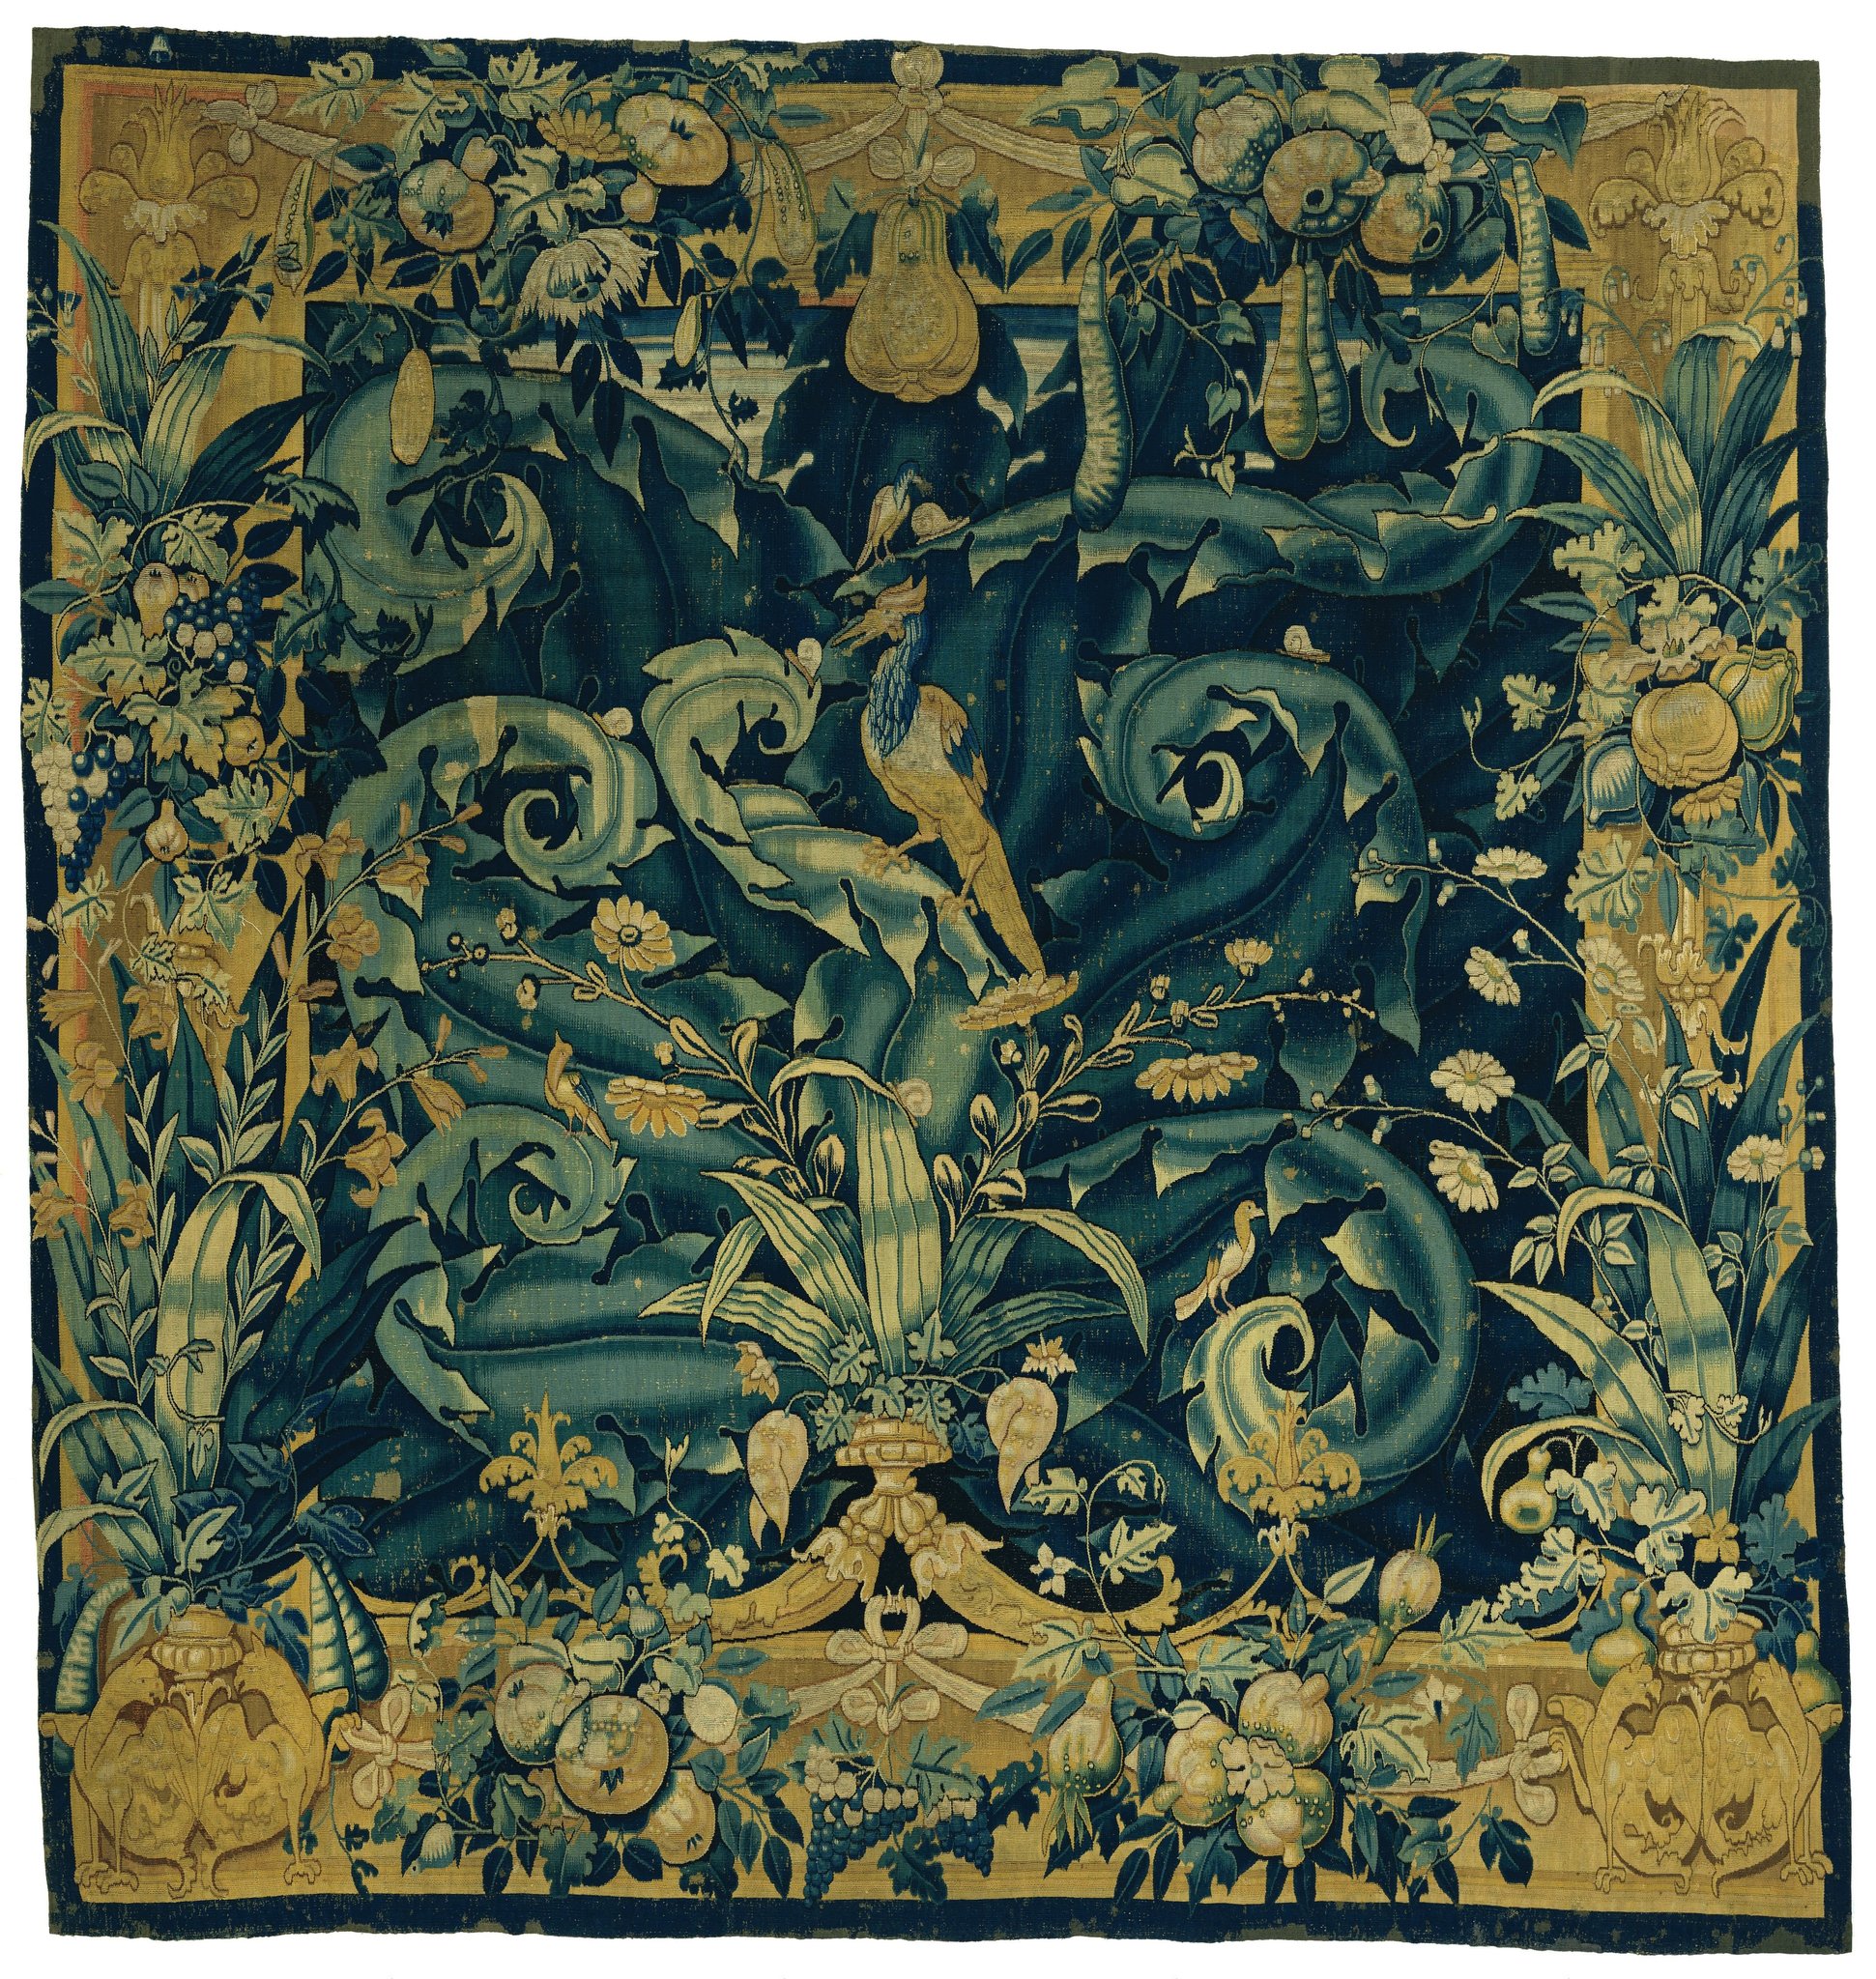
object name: verdure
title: Grootbladige verdure met vogels en slakken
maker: Anonymous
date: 1550-1575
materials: silk, wool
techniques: tapestry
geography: southern netherlands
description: Wandtapijt. Grootbladerige verdure met vogels en slakken. Wol en enige zijde. Zuidelijke Nederlanden, ca. 1550-1575.